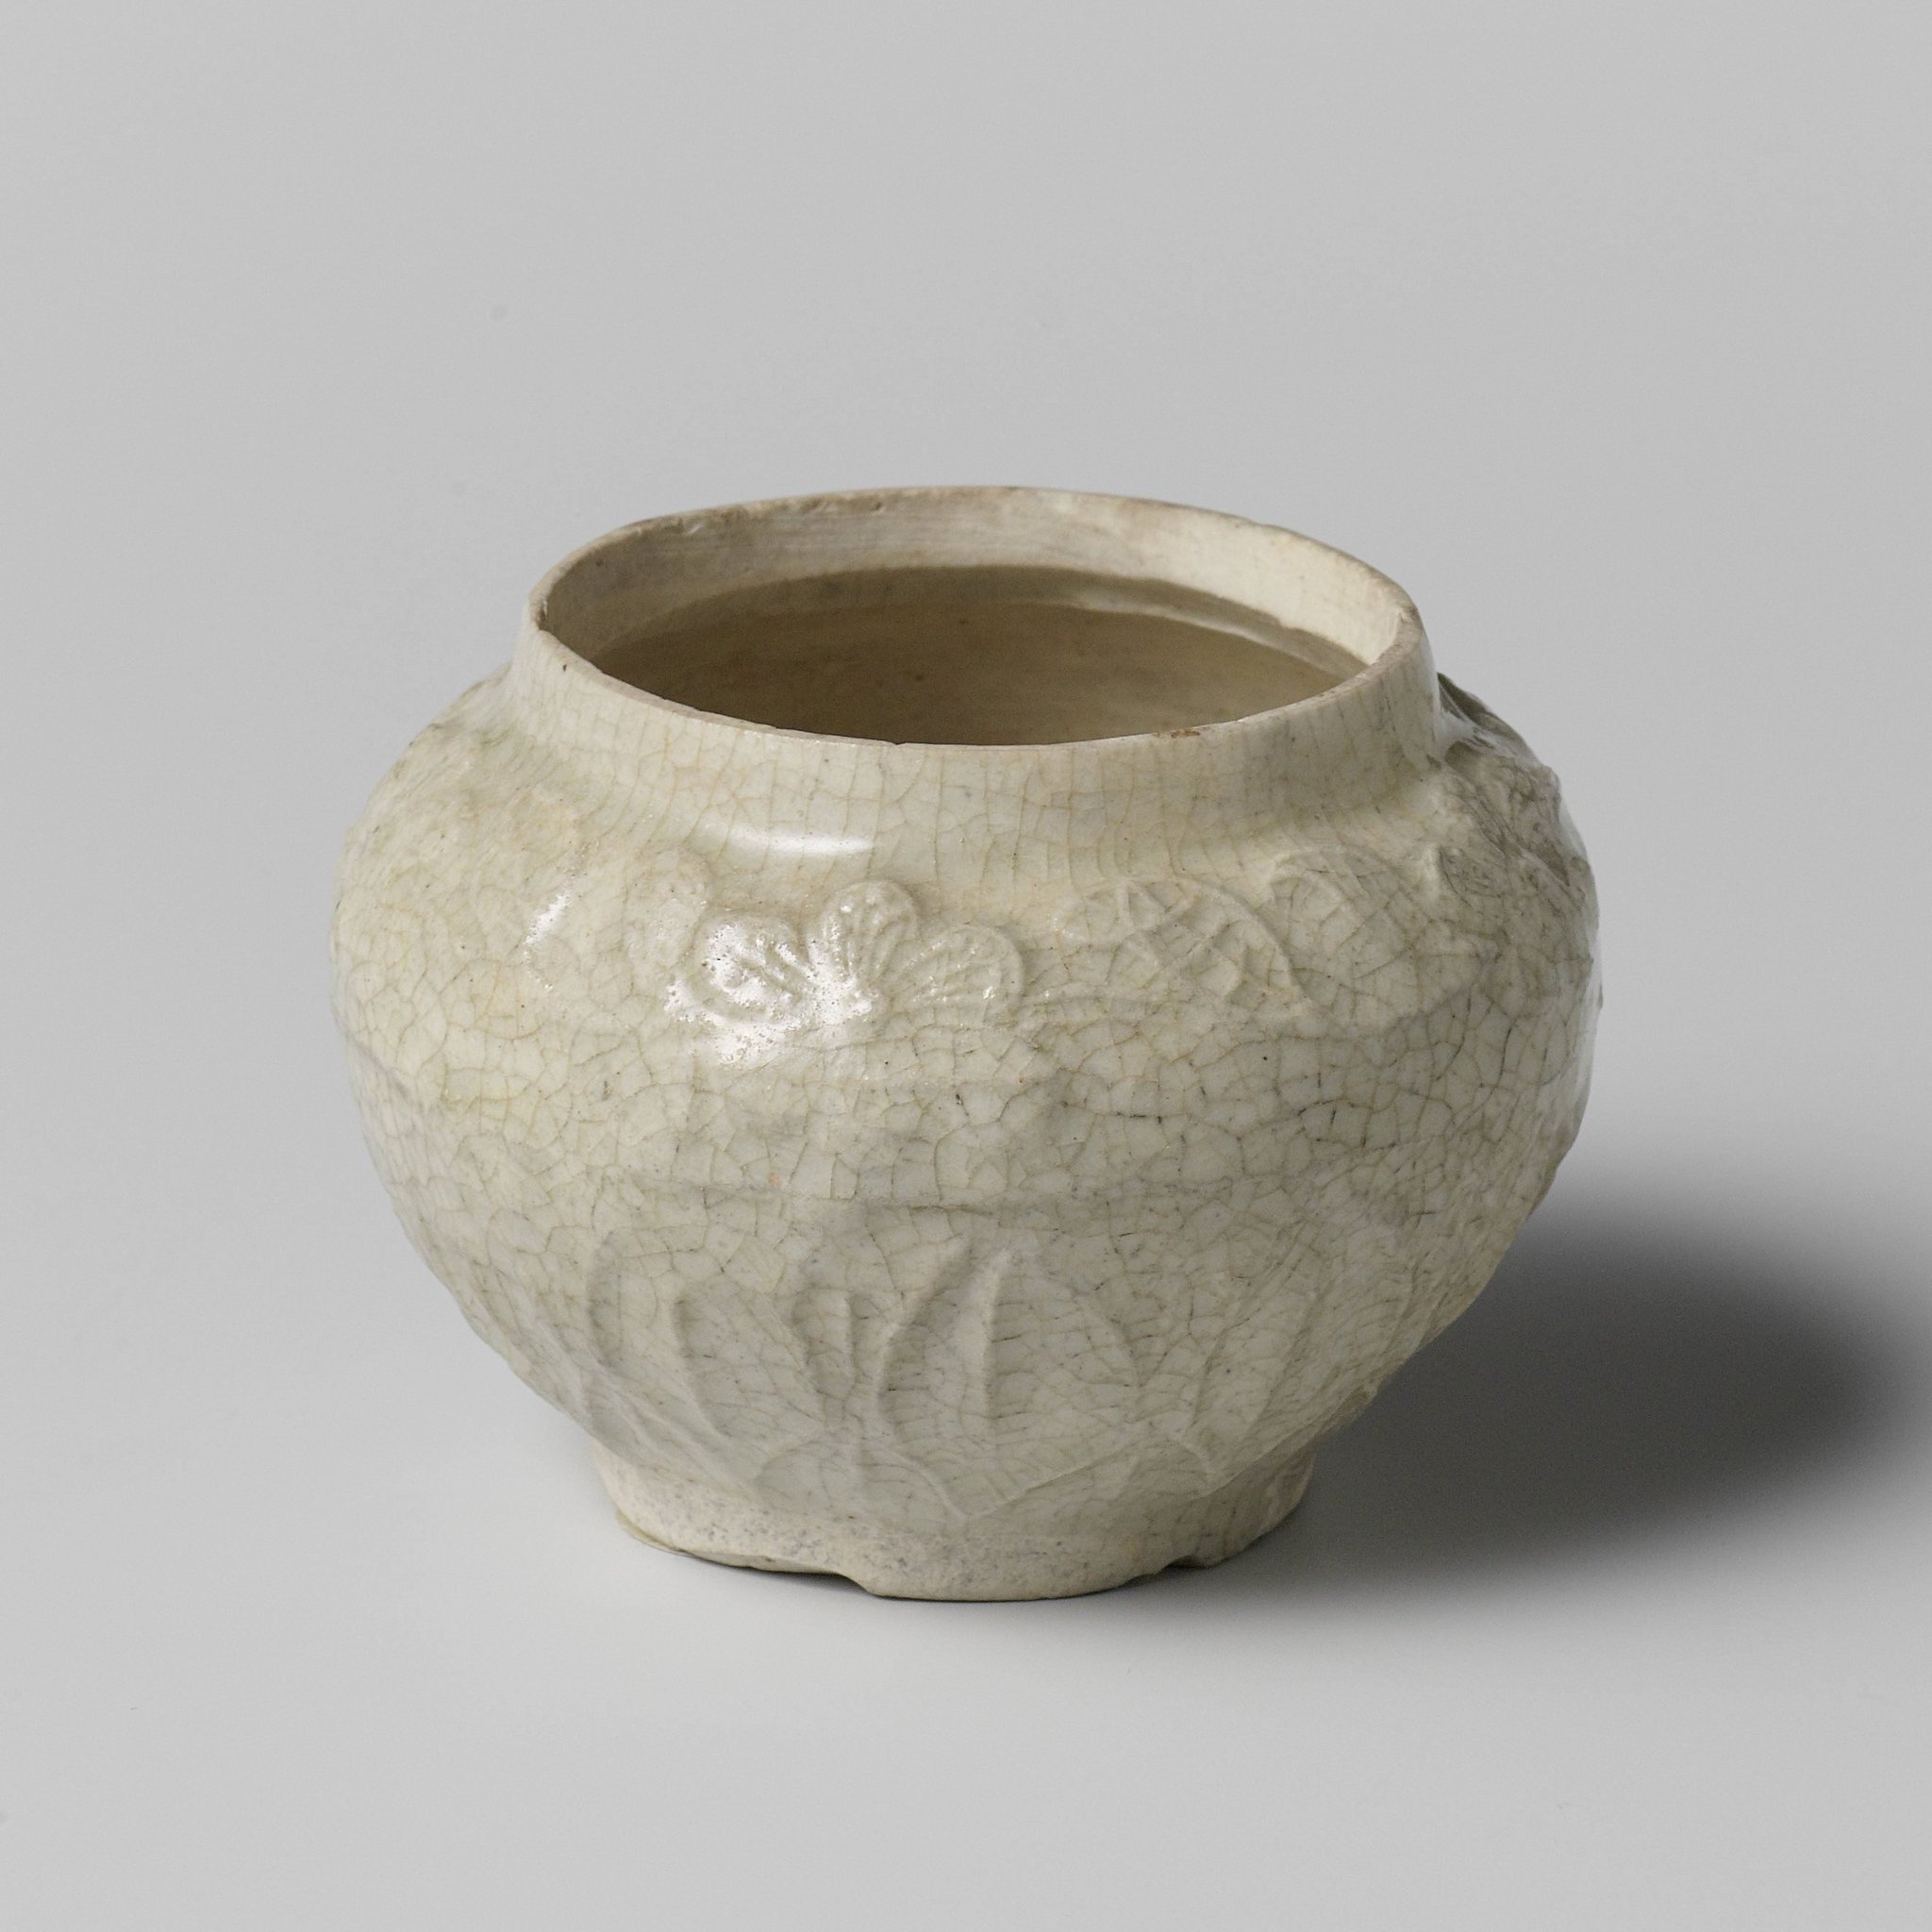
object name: pot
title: Ovoid jar with flower sprays in relief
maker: Anonymous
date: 1279-1368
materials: glaze, stoneware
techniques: firing, relief, turning, vitrification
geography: china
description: Eivormige pot van steengoed, bedekt met een grijsgroen gecraqueleerd glazuur. De buik met twee rijen bladmotieven in reliëf en op de schouder een band met bloemtakken in reliëf. Celadon.